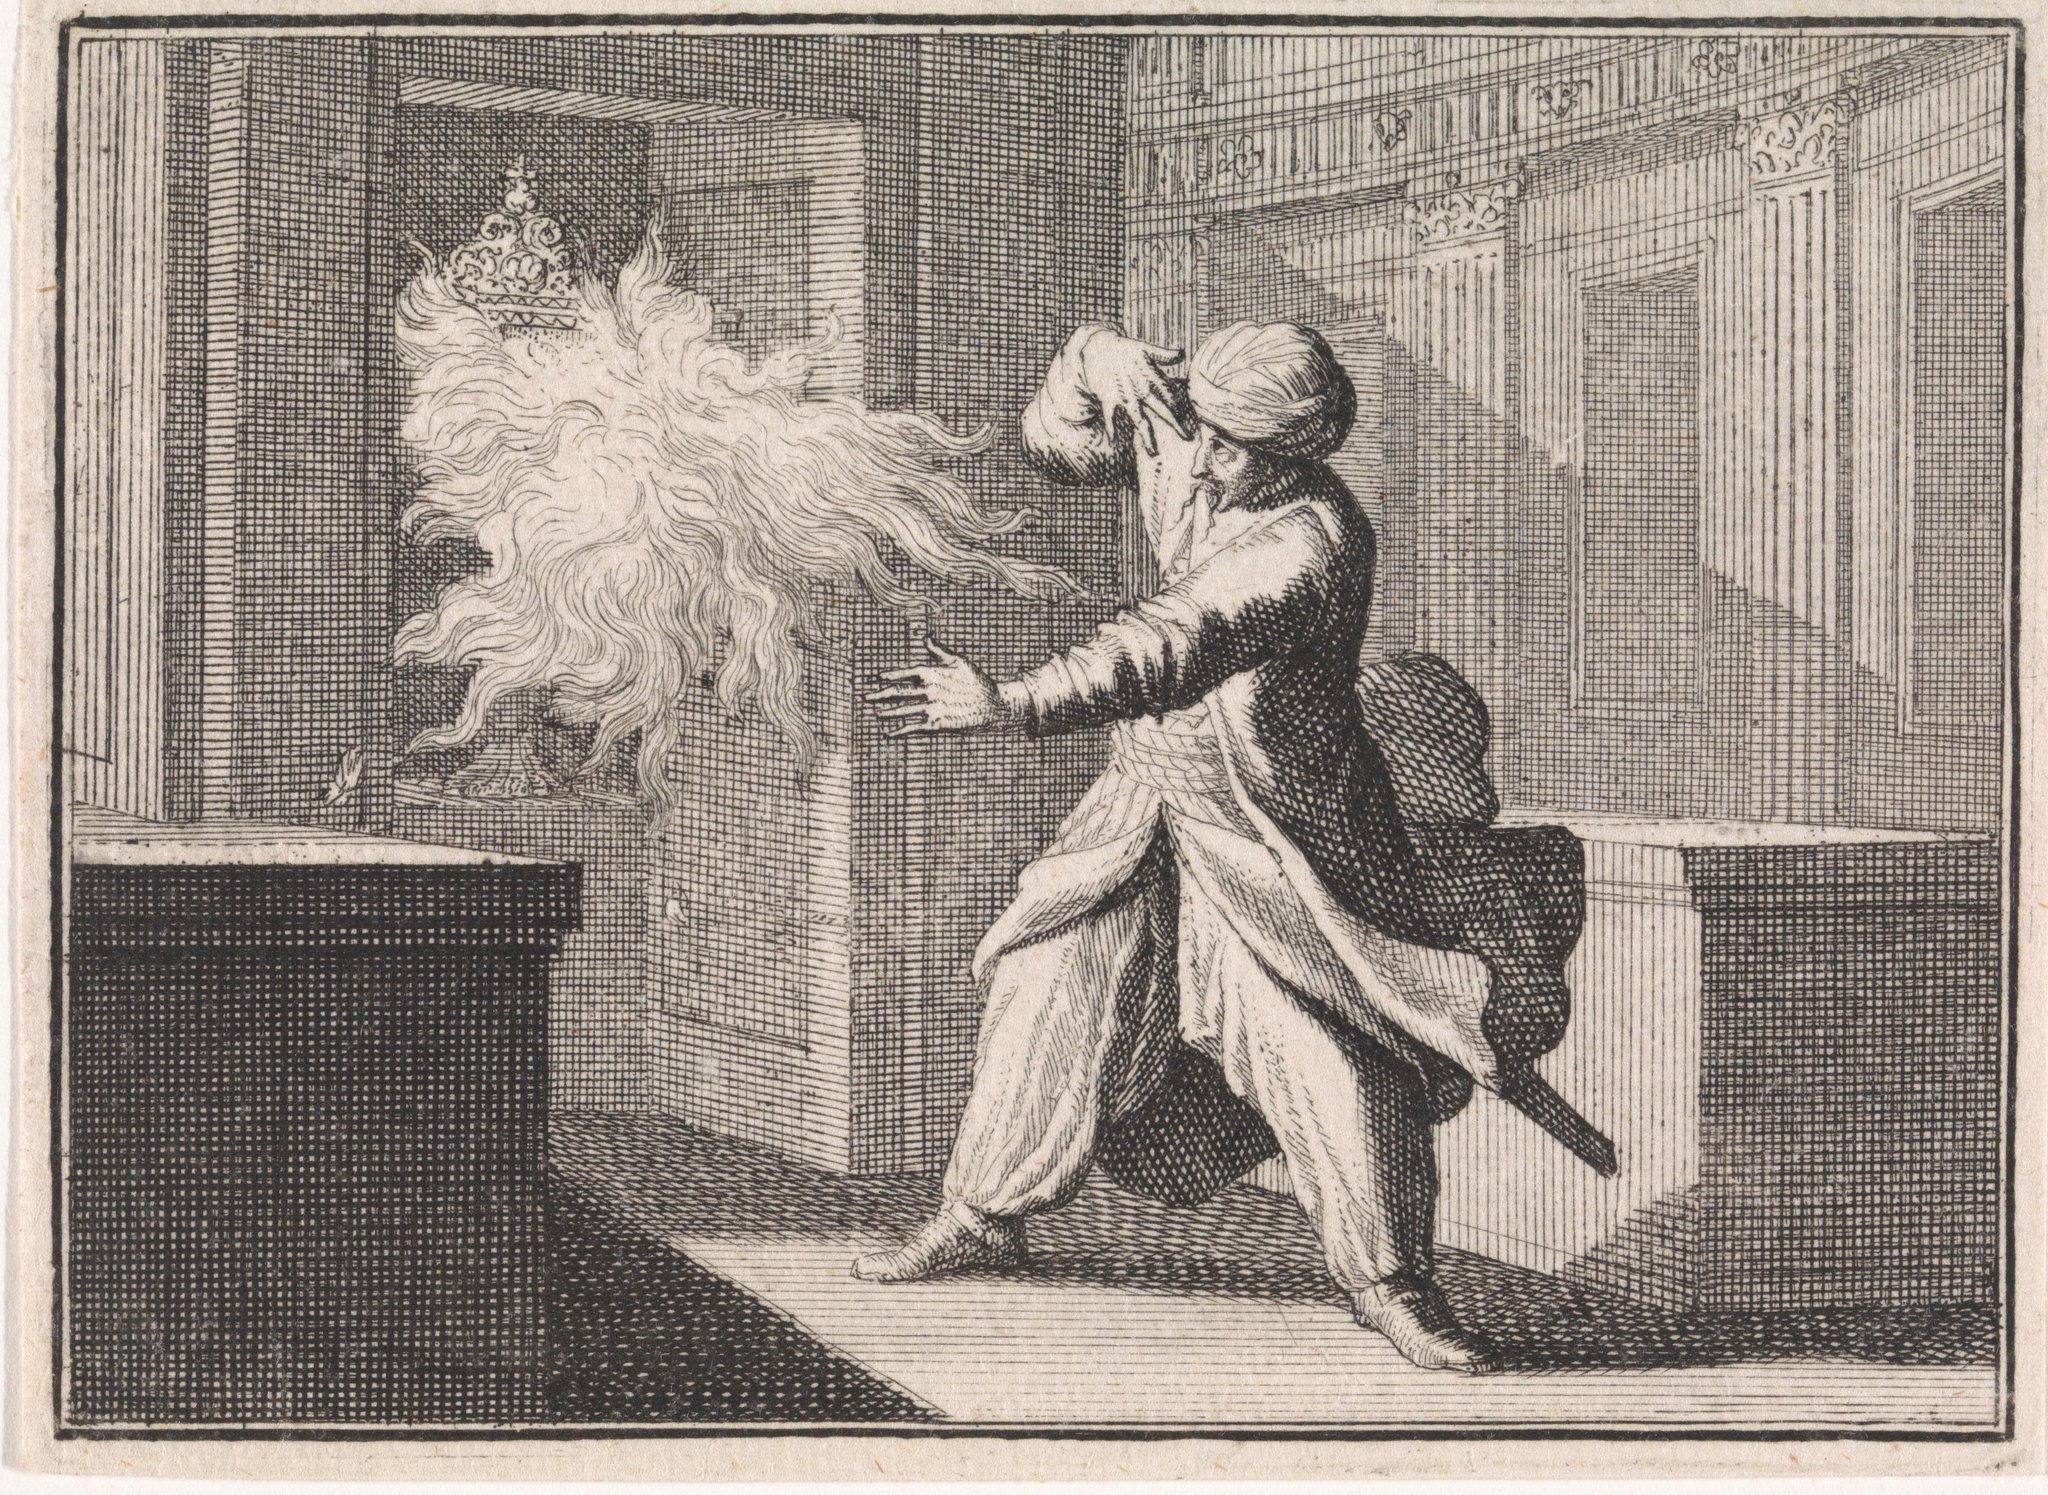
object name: book illustration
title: Oosterse man kijkt uit nieuwsgierigheid in een kast naar een hostiekelk waar als straf een vlam uit slaat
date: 1710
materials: paper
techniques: etching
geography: nuremberg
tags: bread, host (+ variant), head-gear: turban, flame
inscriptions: collector's mark: Lugt 240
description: Illustratie uit: Abraham a Sancta Clara. Heilsames Gemisch Gemasch, das ist: Allerley seltsame und verwunderliche Geschichten (...). Neurenberg: Christoph Weigel, 1710, p. 182.